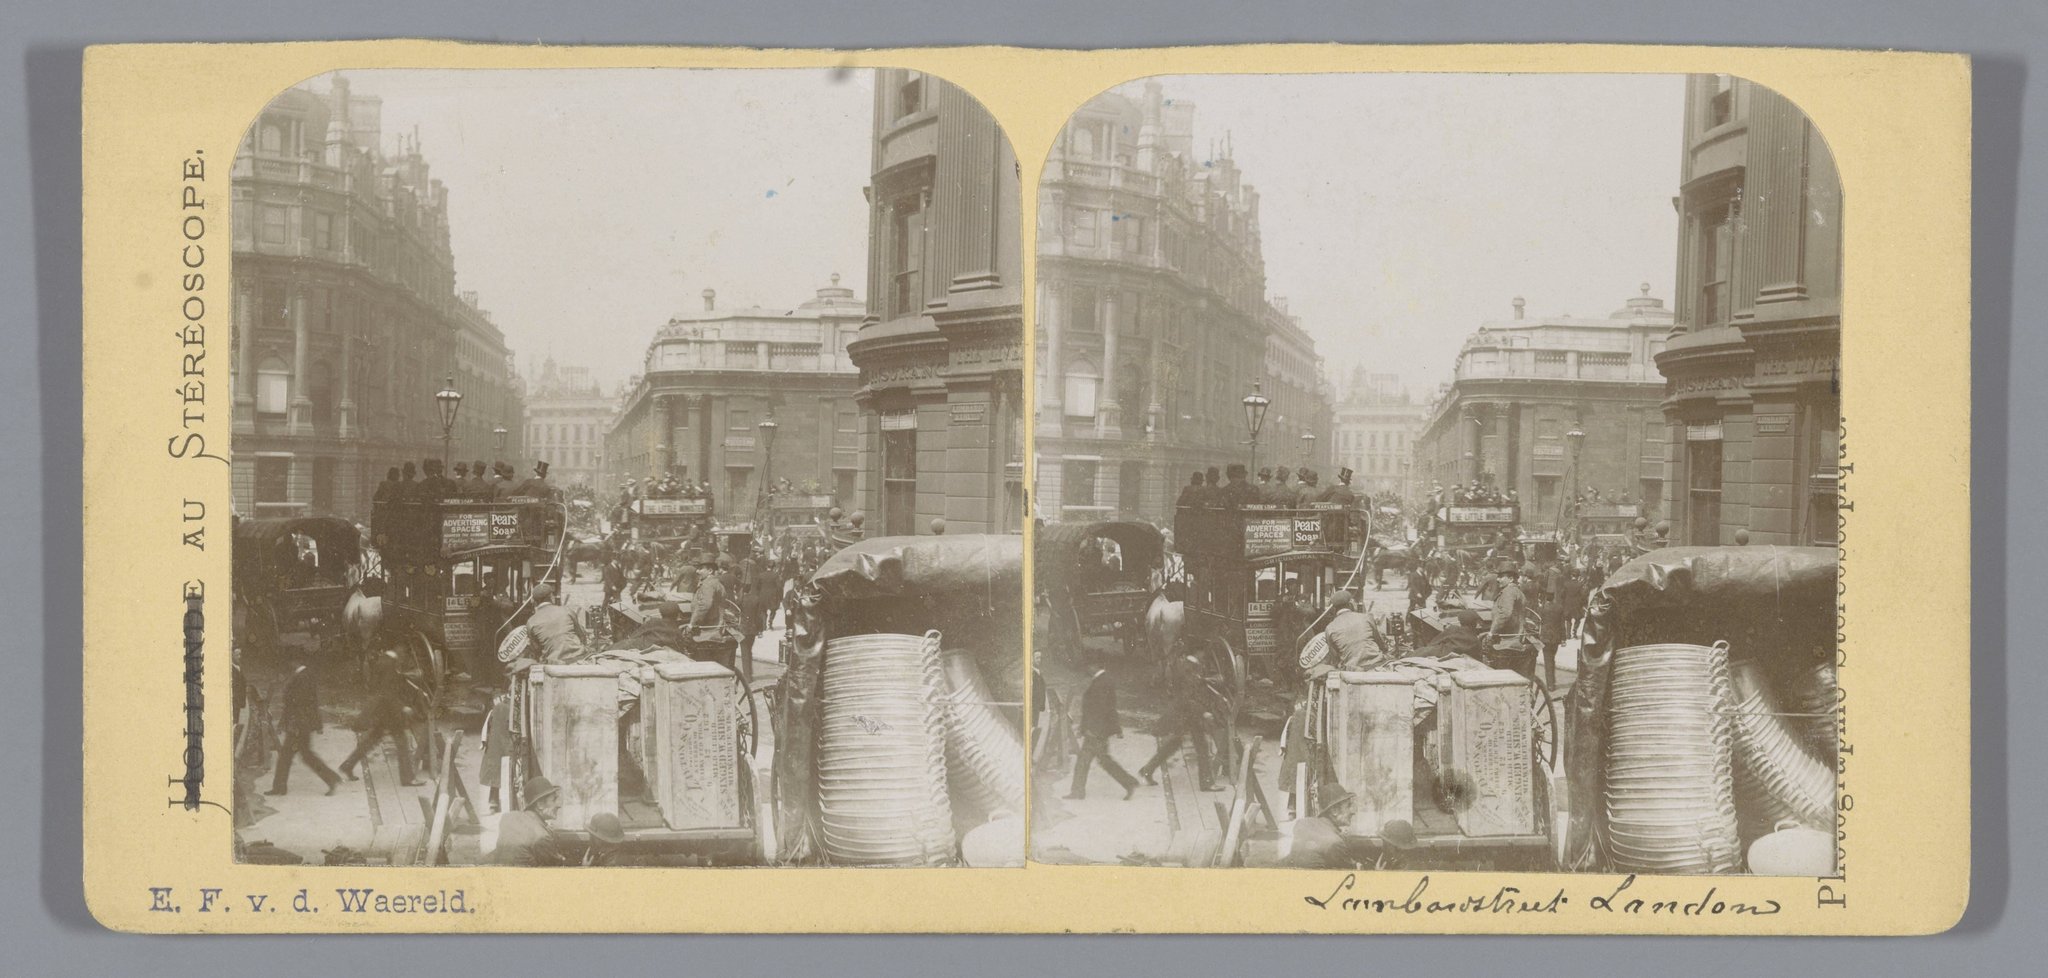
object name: stereograph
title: Gezicht op Lombard Street te Londen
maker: eduard frederik van de waereld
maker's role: draughtsman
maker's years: 1857-1941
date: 1890-1910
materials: cardboard, photographic support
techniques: collodion silver print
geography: london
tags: four-wheeled vehicle drawn by one animal, street, london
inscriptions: inscription: ‘Lombardstreet London’, inscription: ‘Hollande au Stéréoscope Photographie Stereoscopique’